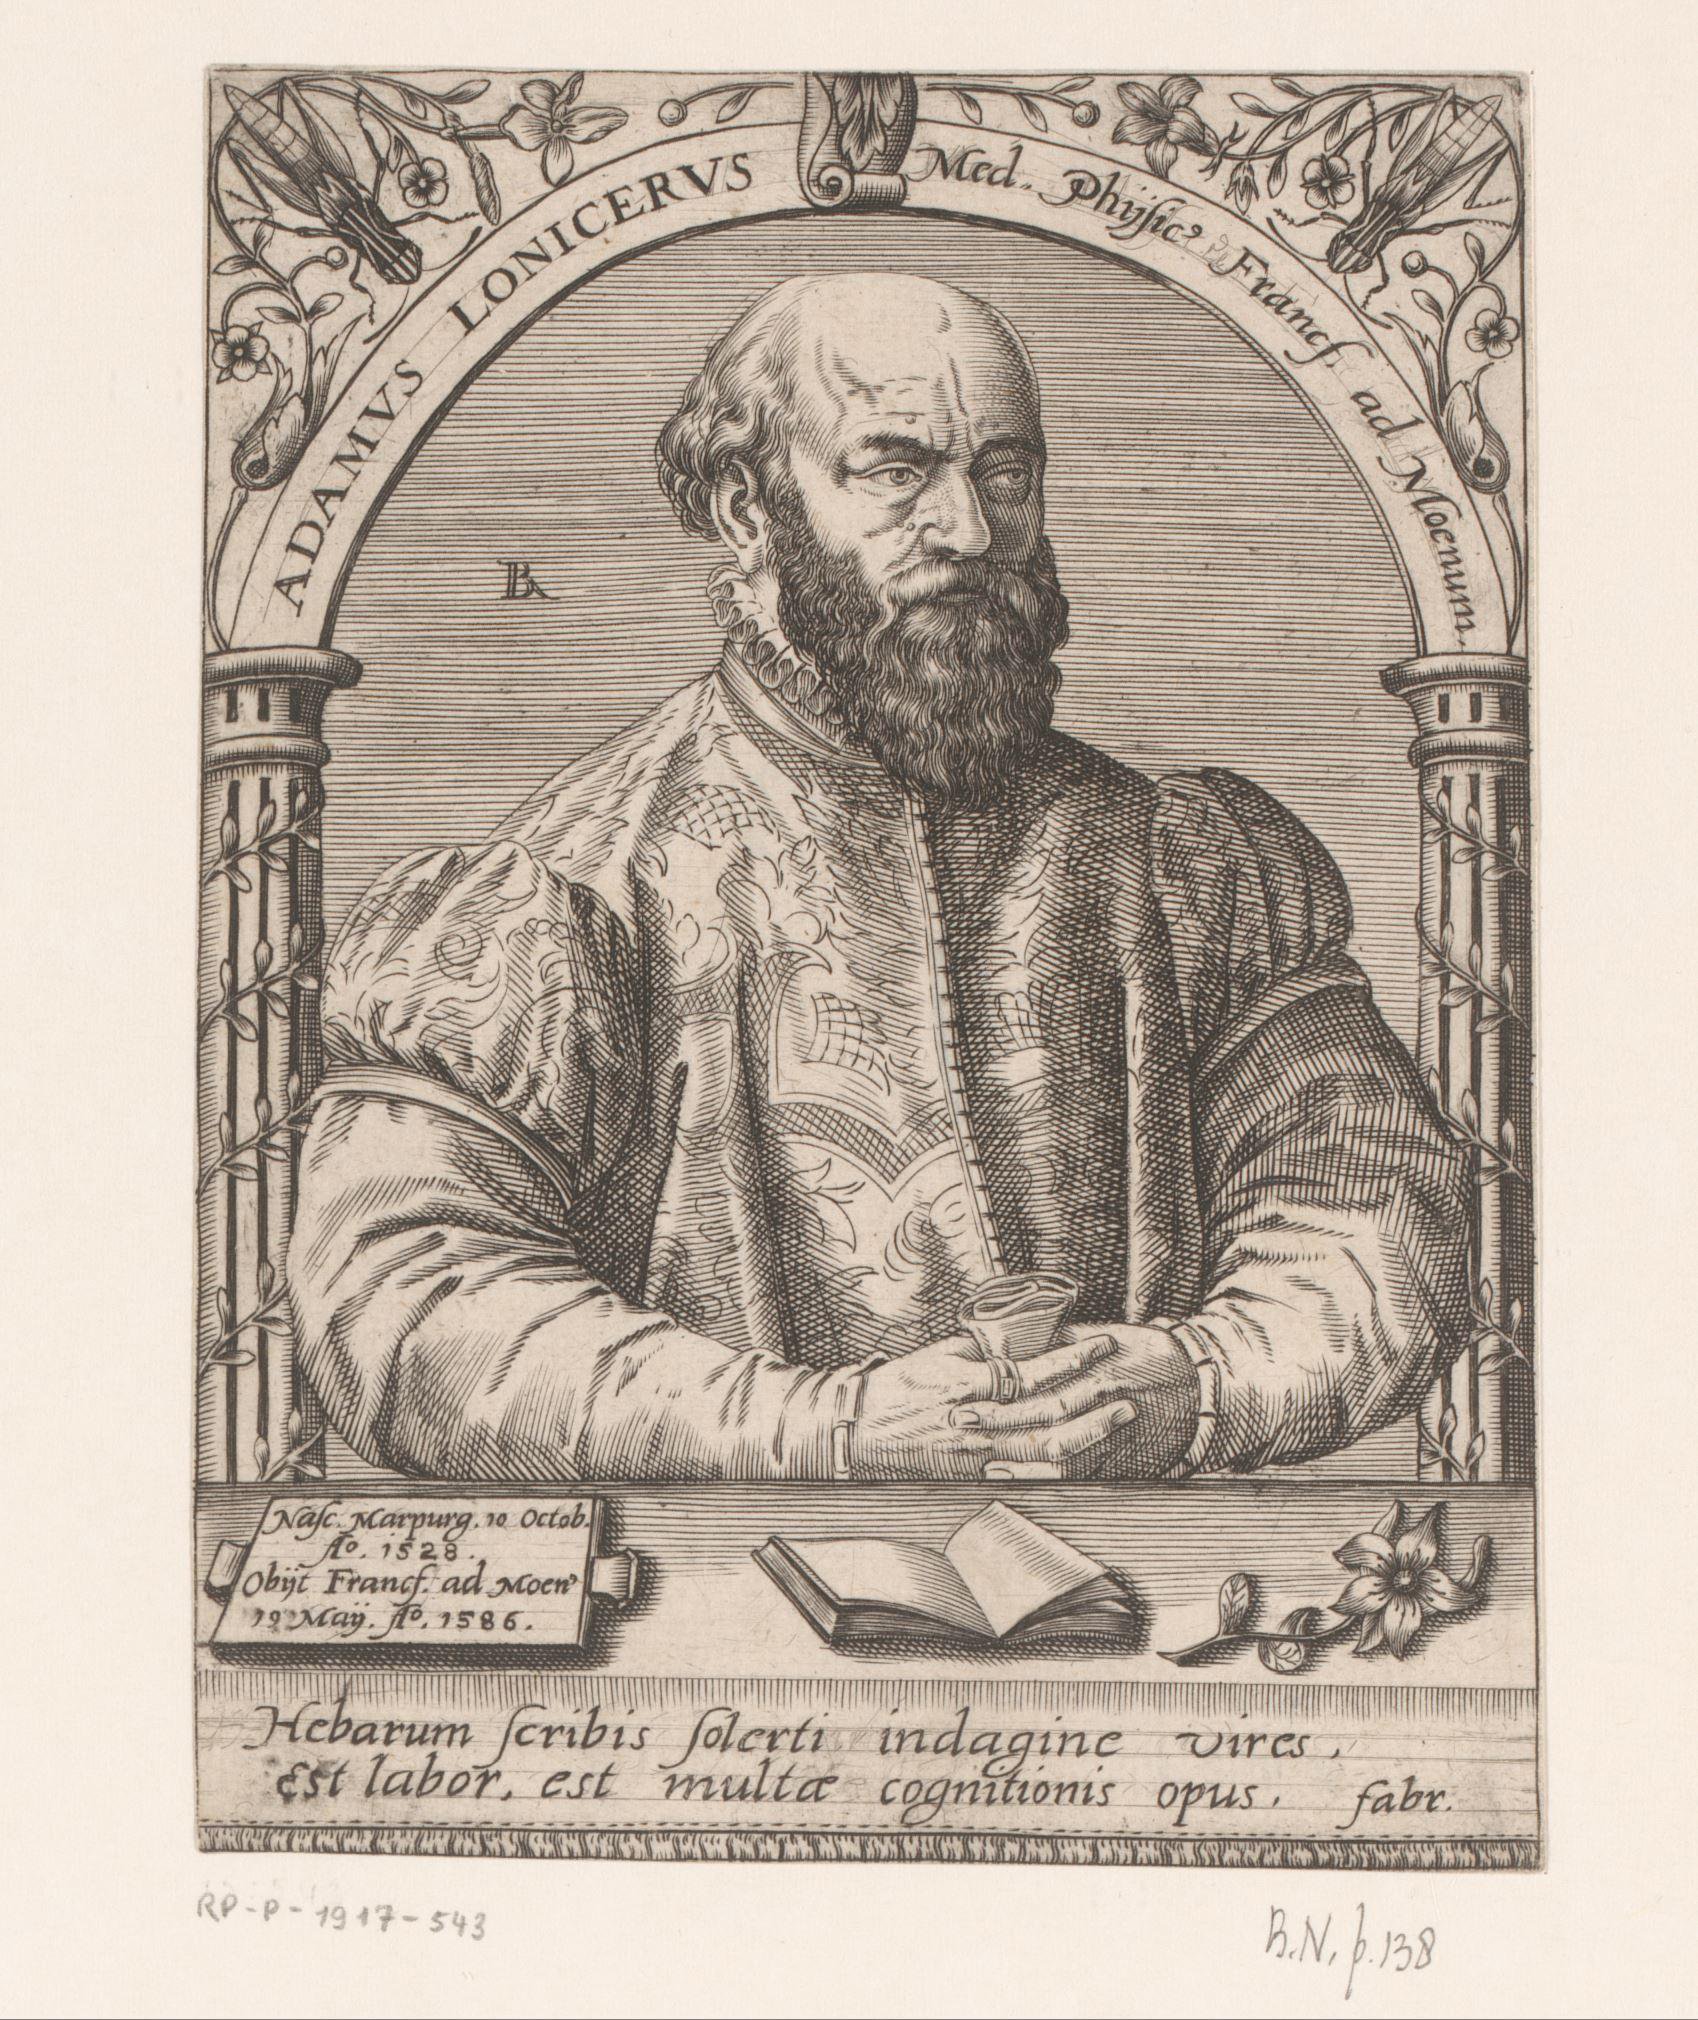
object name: print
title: Serie portretten van vijftiende- en zestiende-eeuwse geleerden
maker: robert boissard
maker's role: print maker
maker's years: 1570-1611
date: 1597-1599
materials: paper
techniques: engraving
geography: france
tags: physicist, flowers ~ ornament - aa - stylized, insects: grass-hopper - ff - fabulous animals (sometimes wrongly called 'grotesques'; 'mostri' (ripa), historical persons, armorial bearing, heraldry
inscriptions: collector's mark: Lugt 2228